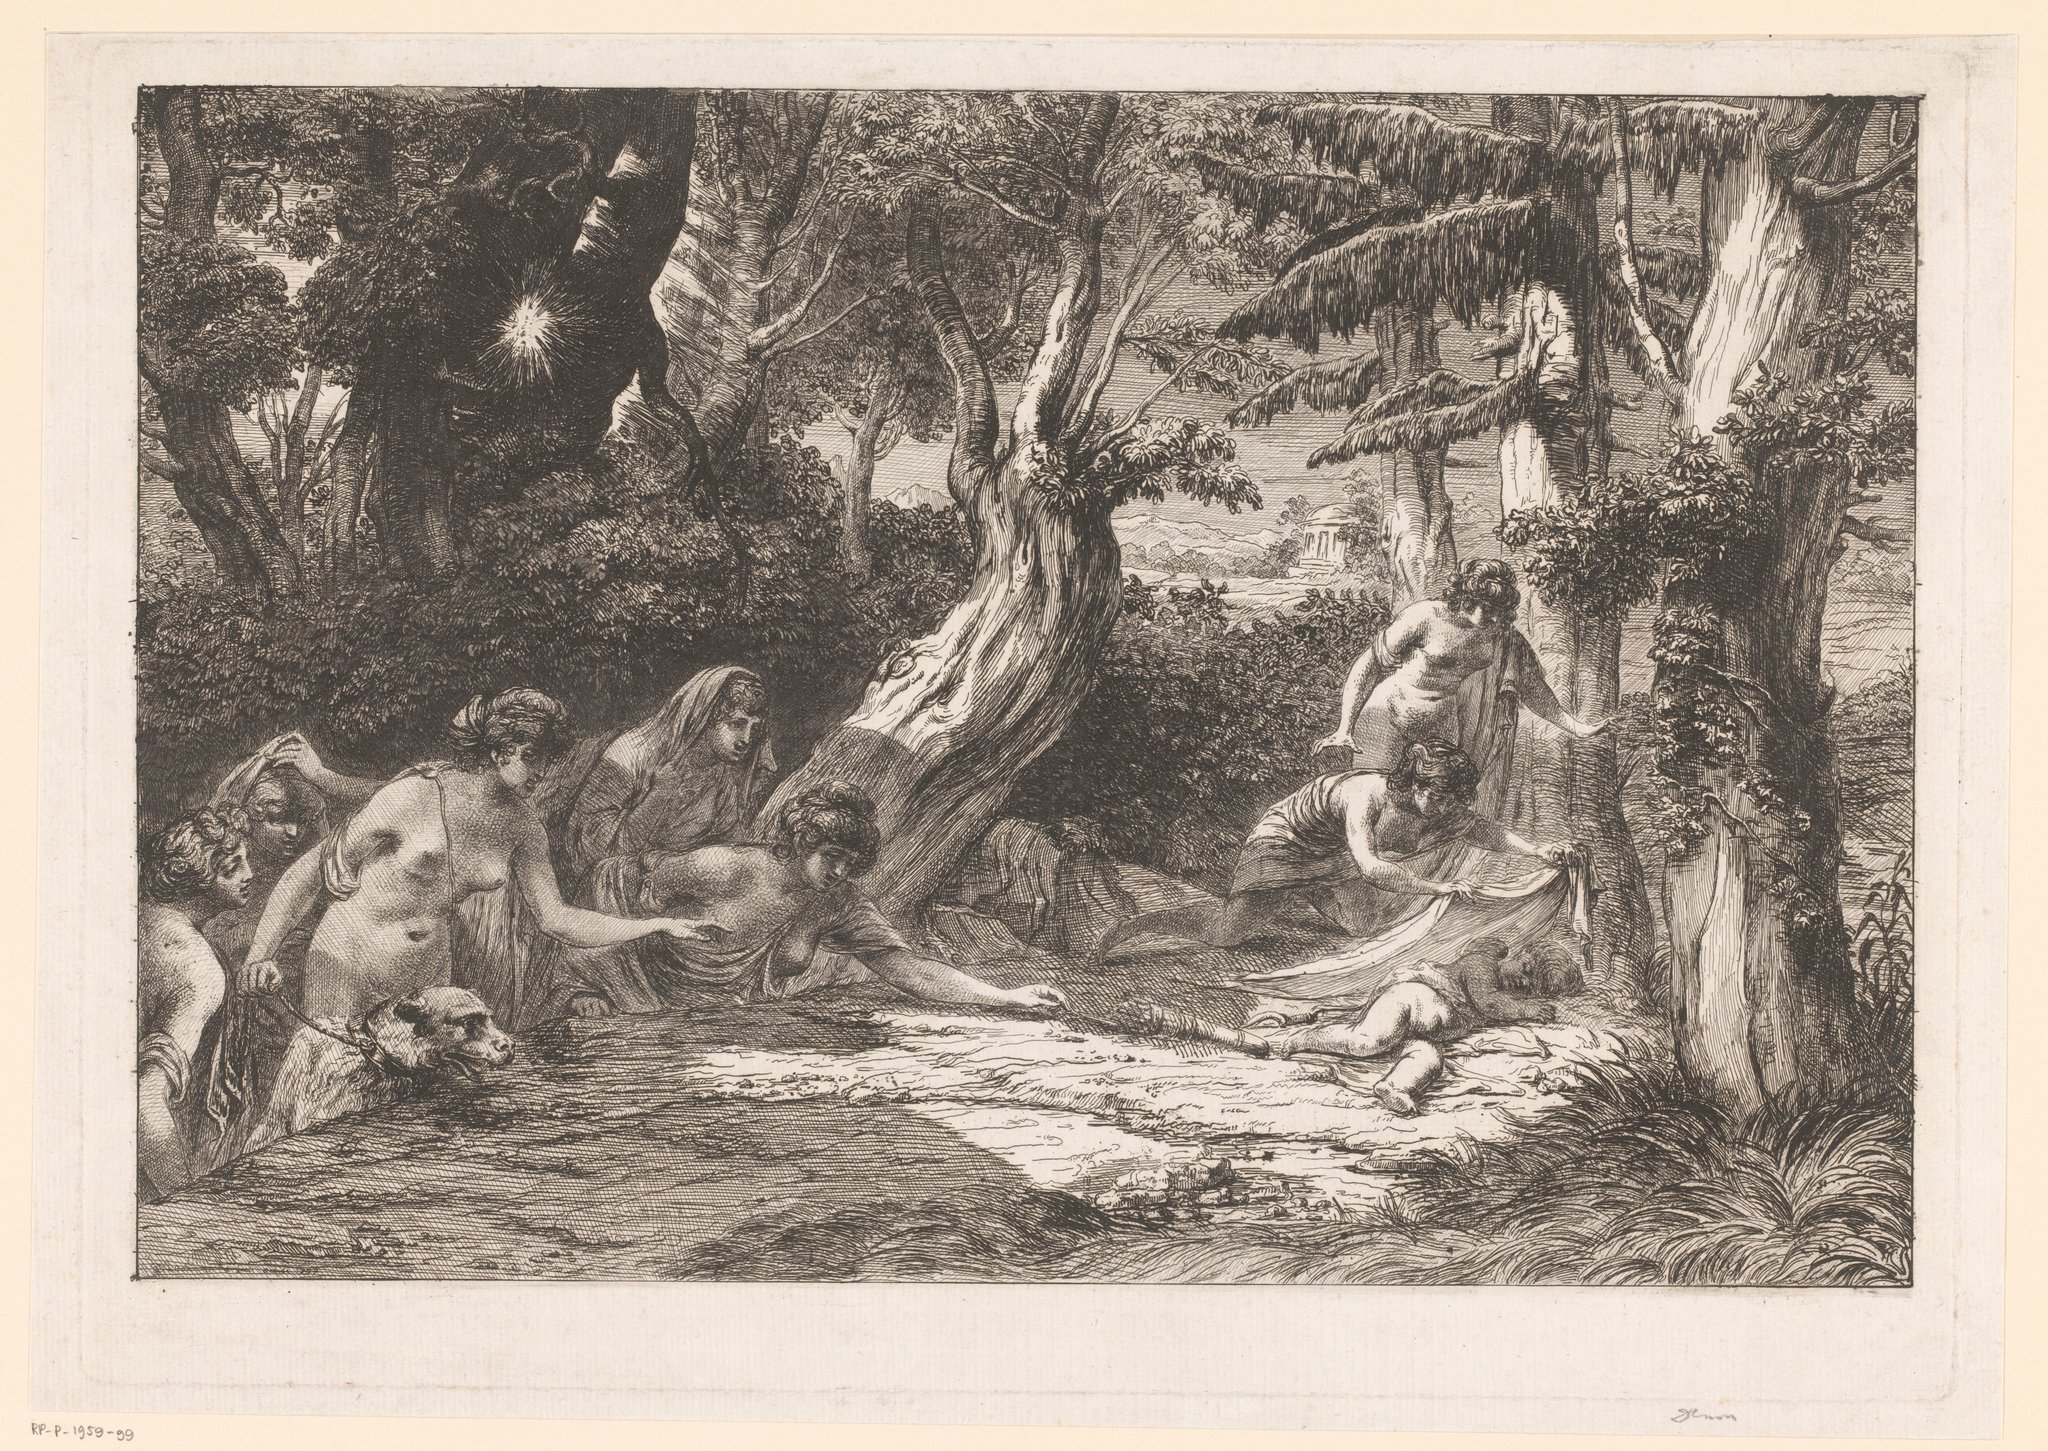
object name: print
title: Diana en haar nimfen vinden de slapende Cupido in het bos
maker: dominique vivant denon (baron)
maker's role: draughtsman, print maker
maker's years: 1747-1825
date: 1792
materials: paper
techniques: etching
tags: companions, nymphs of diana; 'ninfe di diana' (ripa), diana hunting with her nymphs, sleeping cupid; possibly signifying a slackening of love's influence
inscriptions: collector's mark: Lugt 2228, collector's mark: Lugt 2760